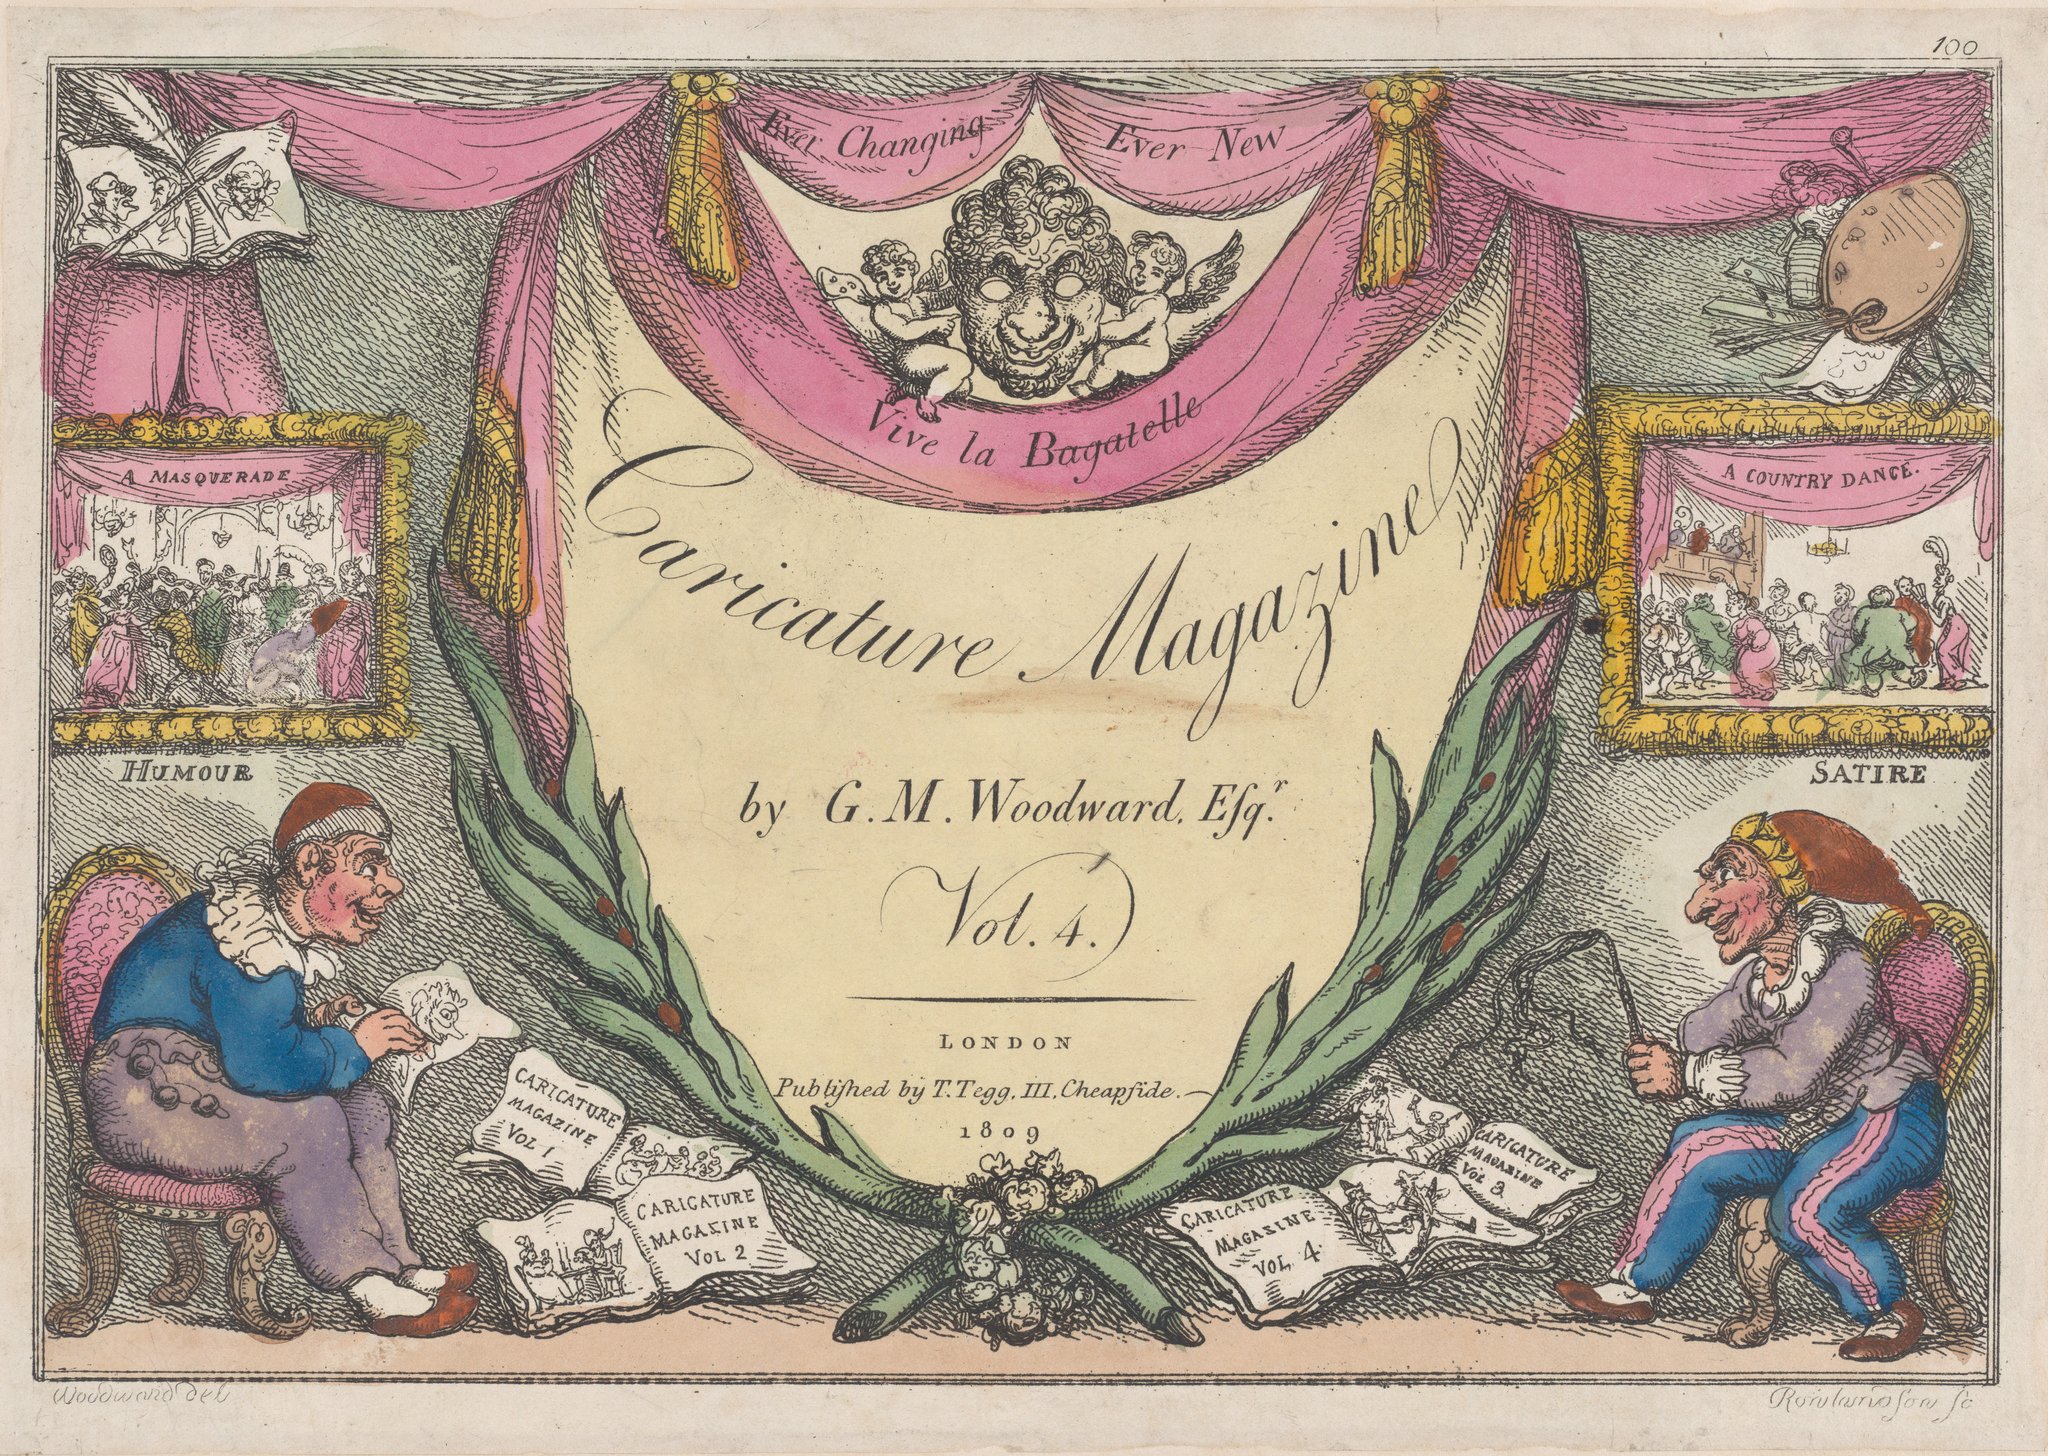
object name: print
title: Title Page, The Caricature Magazine by G. M. Woodward, Vol. 4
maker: thomas rowlandson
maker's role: artist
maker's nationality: british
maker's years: 1757-1827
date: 1809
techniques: etching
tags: satire,caricature